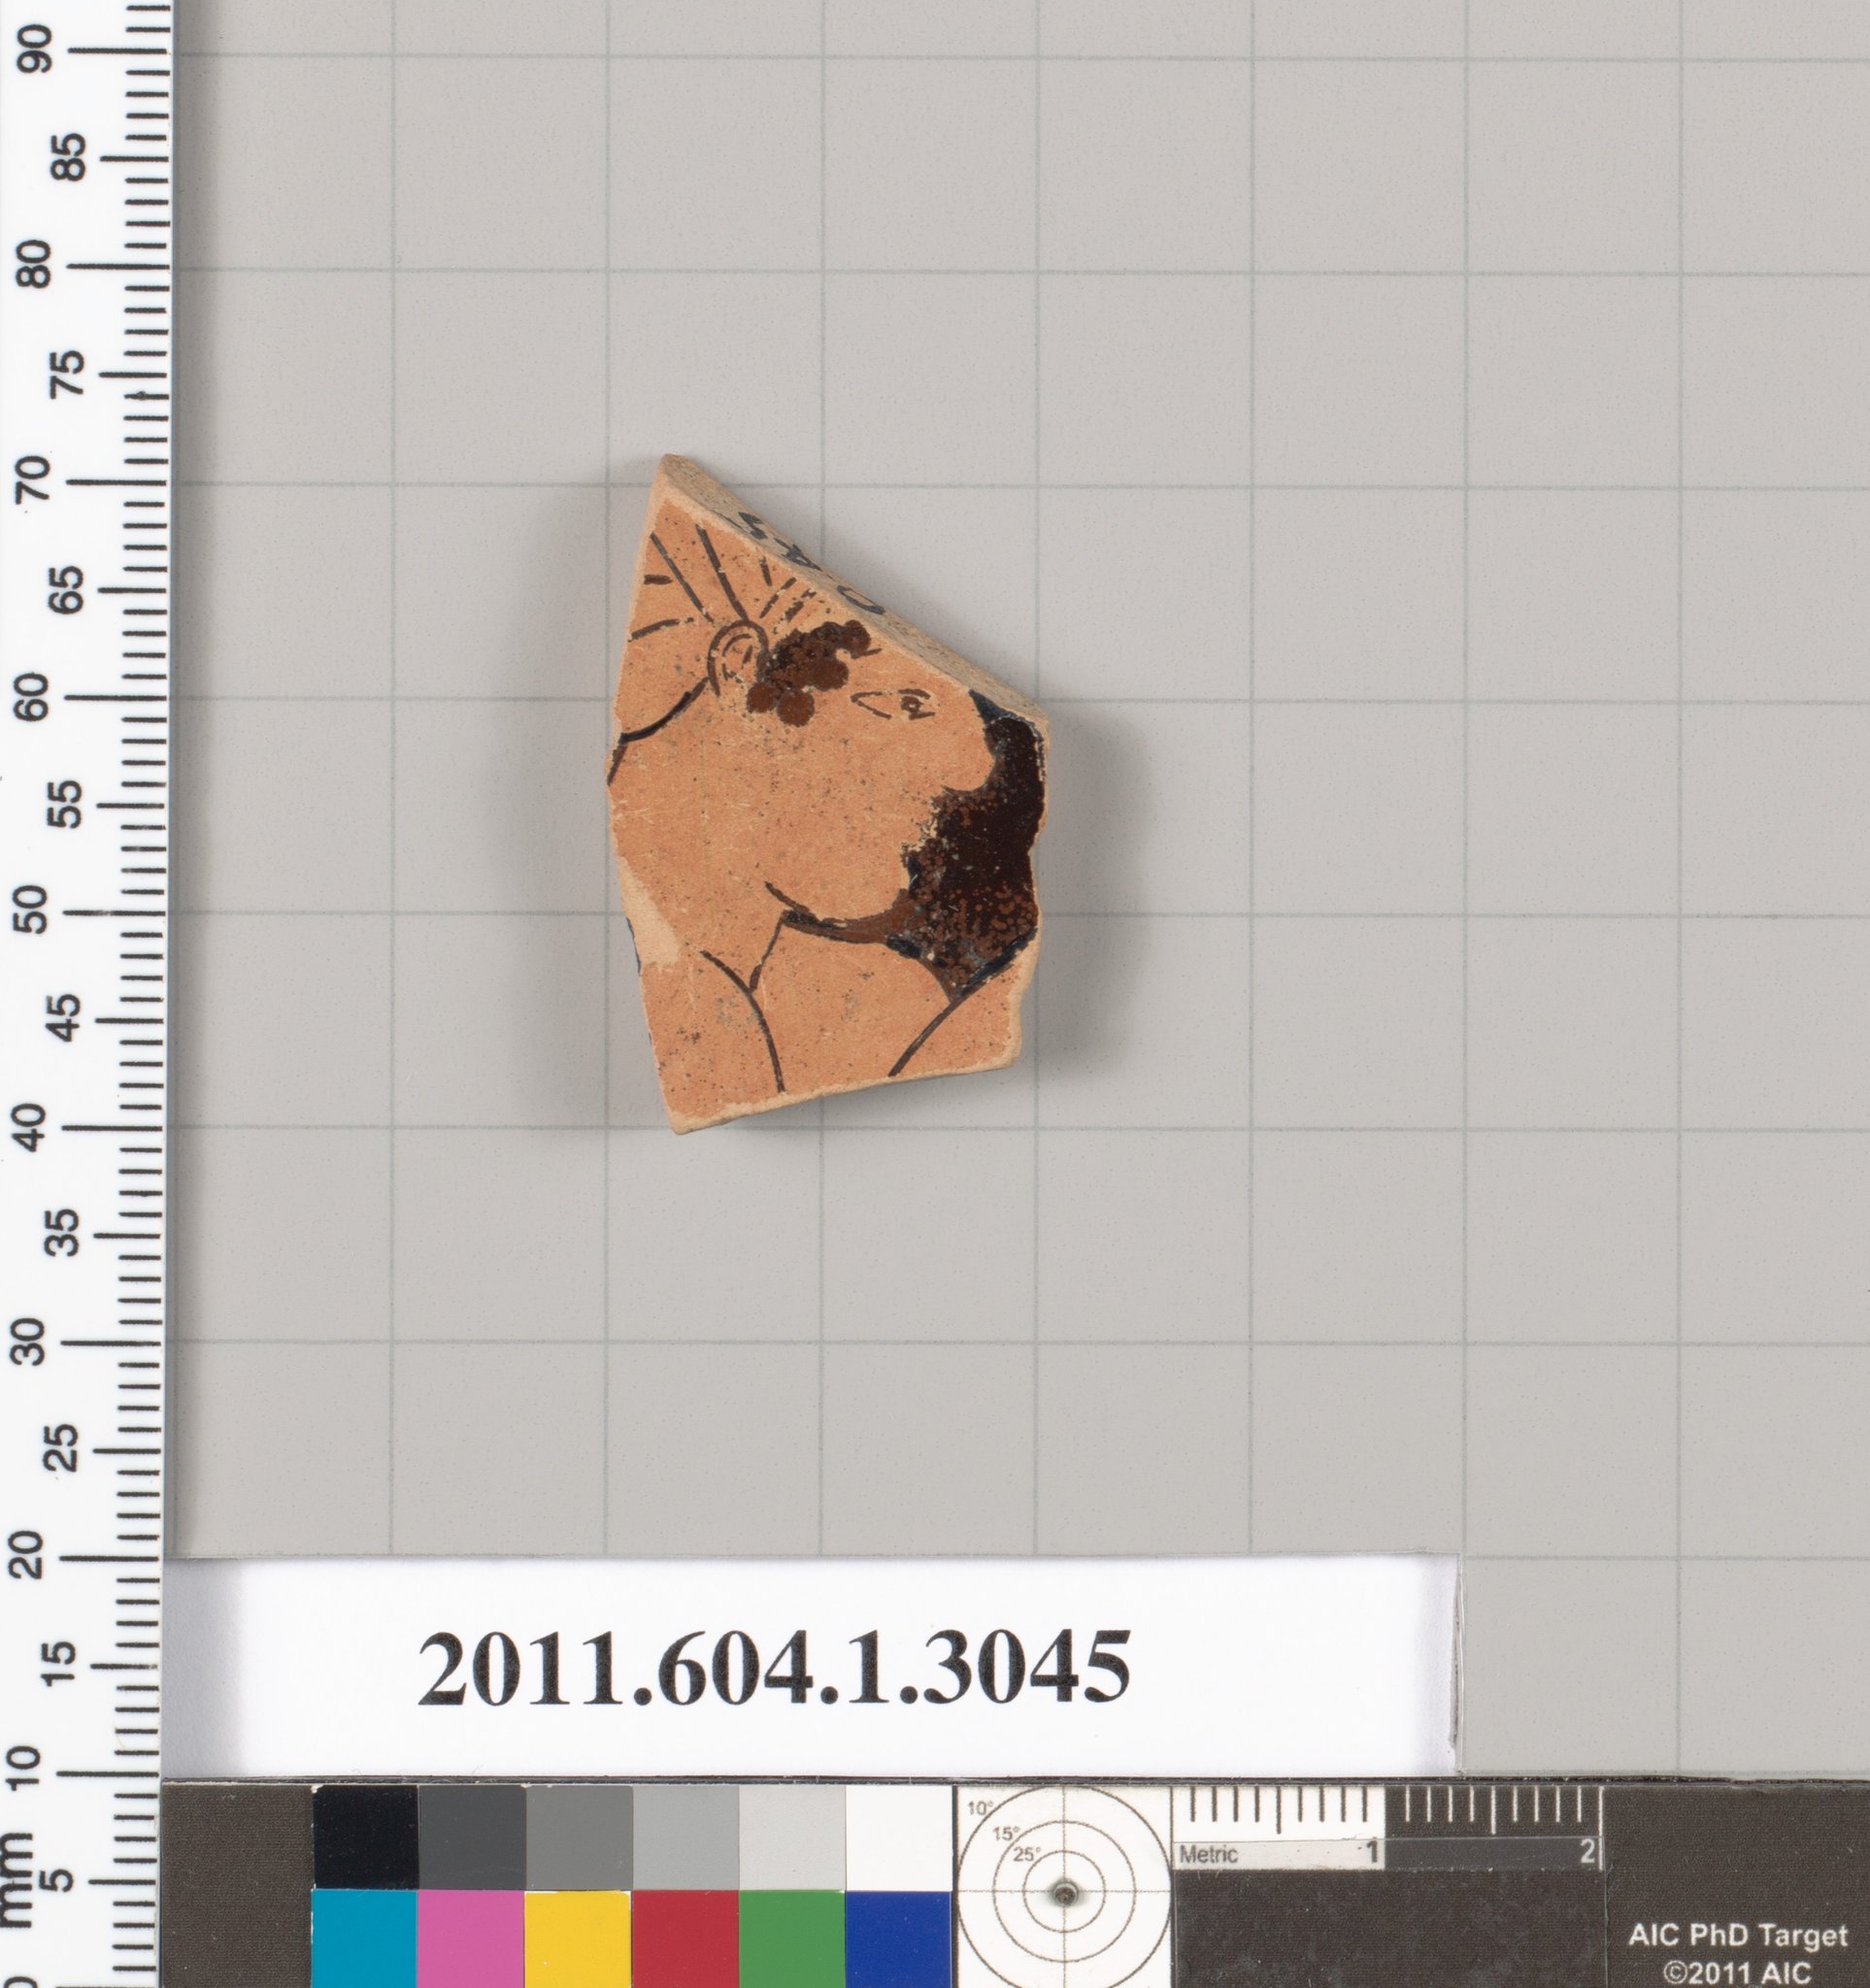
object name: kylix fragment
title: Terracotta fragment of a kylix (drinking cup)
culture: greek, attic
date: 490-480 BCE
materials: terracotta